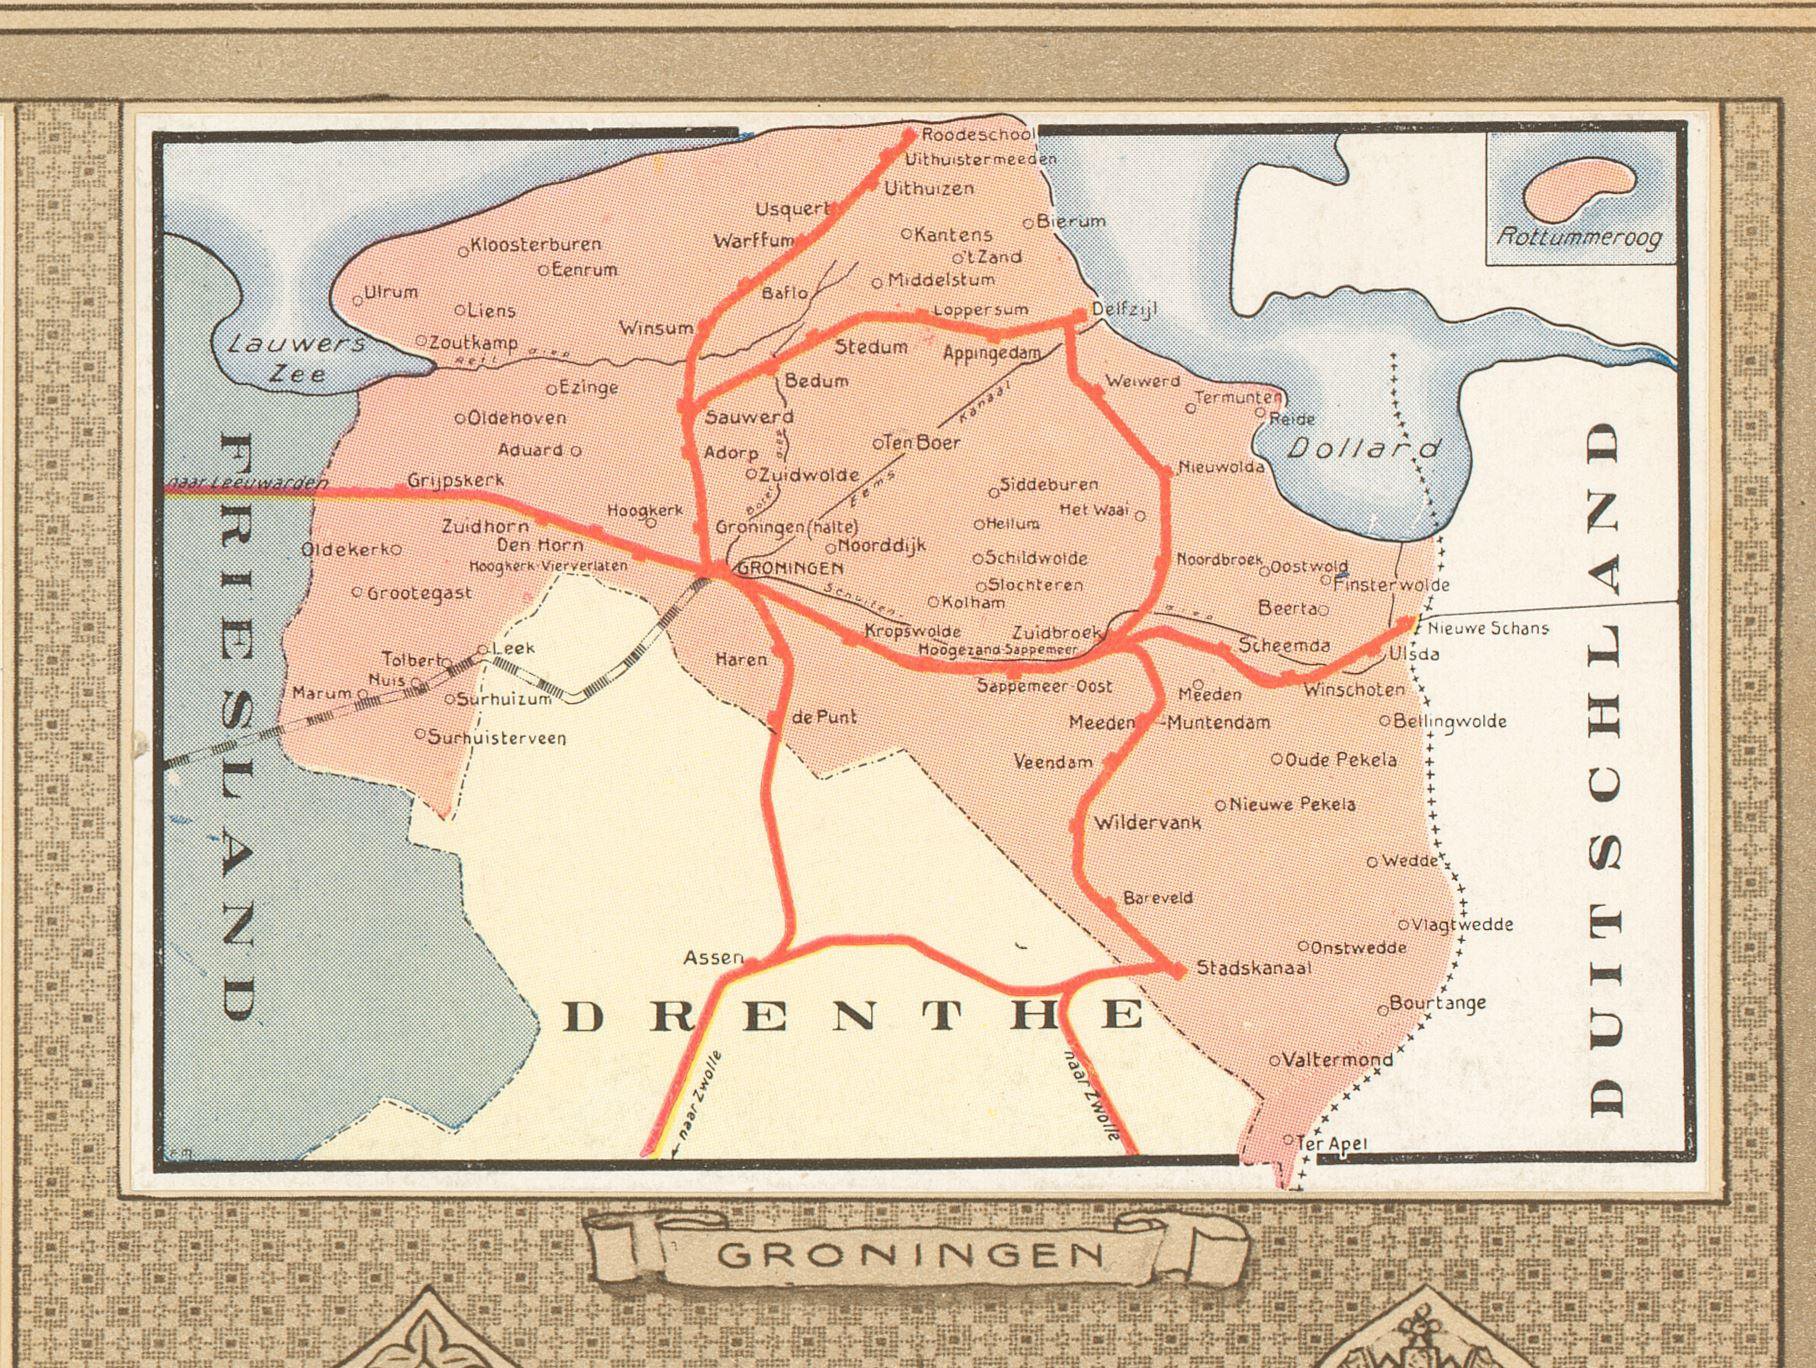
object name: album leaf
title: Spoorwegenkaart van Groningen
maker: Anonymous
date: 1915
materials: paper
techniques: printing block, rotogravure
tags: maps of separate countries or regions, railway, tramway; rack railway, groningen (province)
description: Deze prent maakt deel uit van een album.